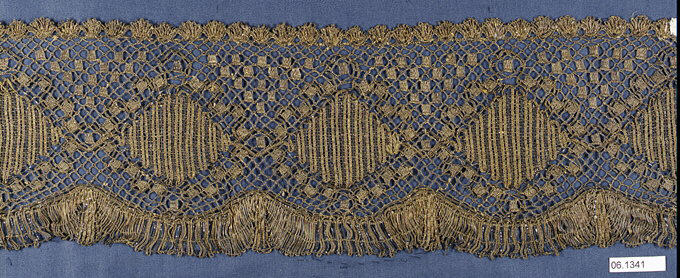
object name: fragment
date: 1601-1700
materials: metal thread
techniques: lace